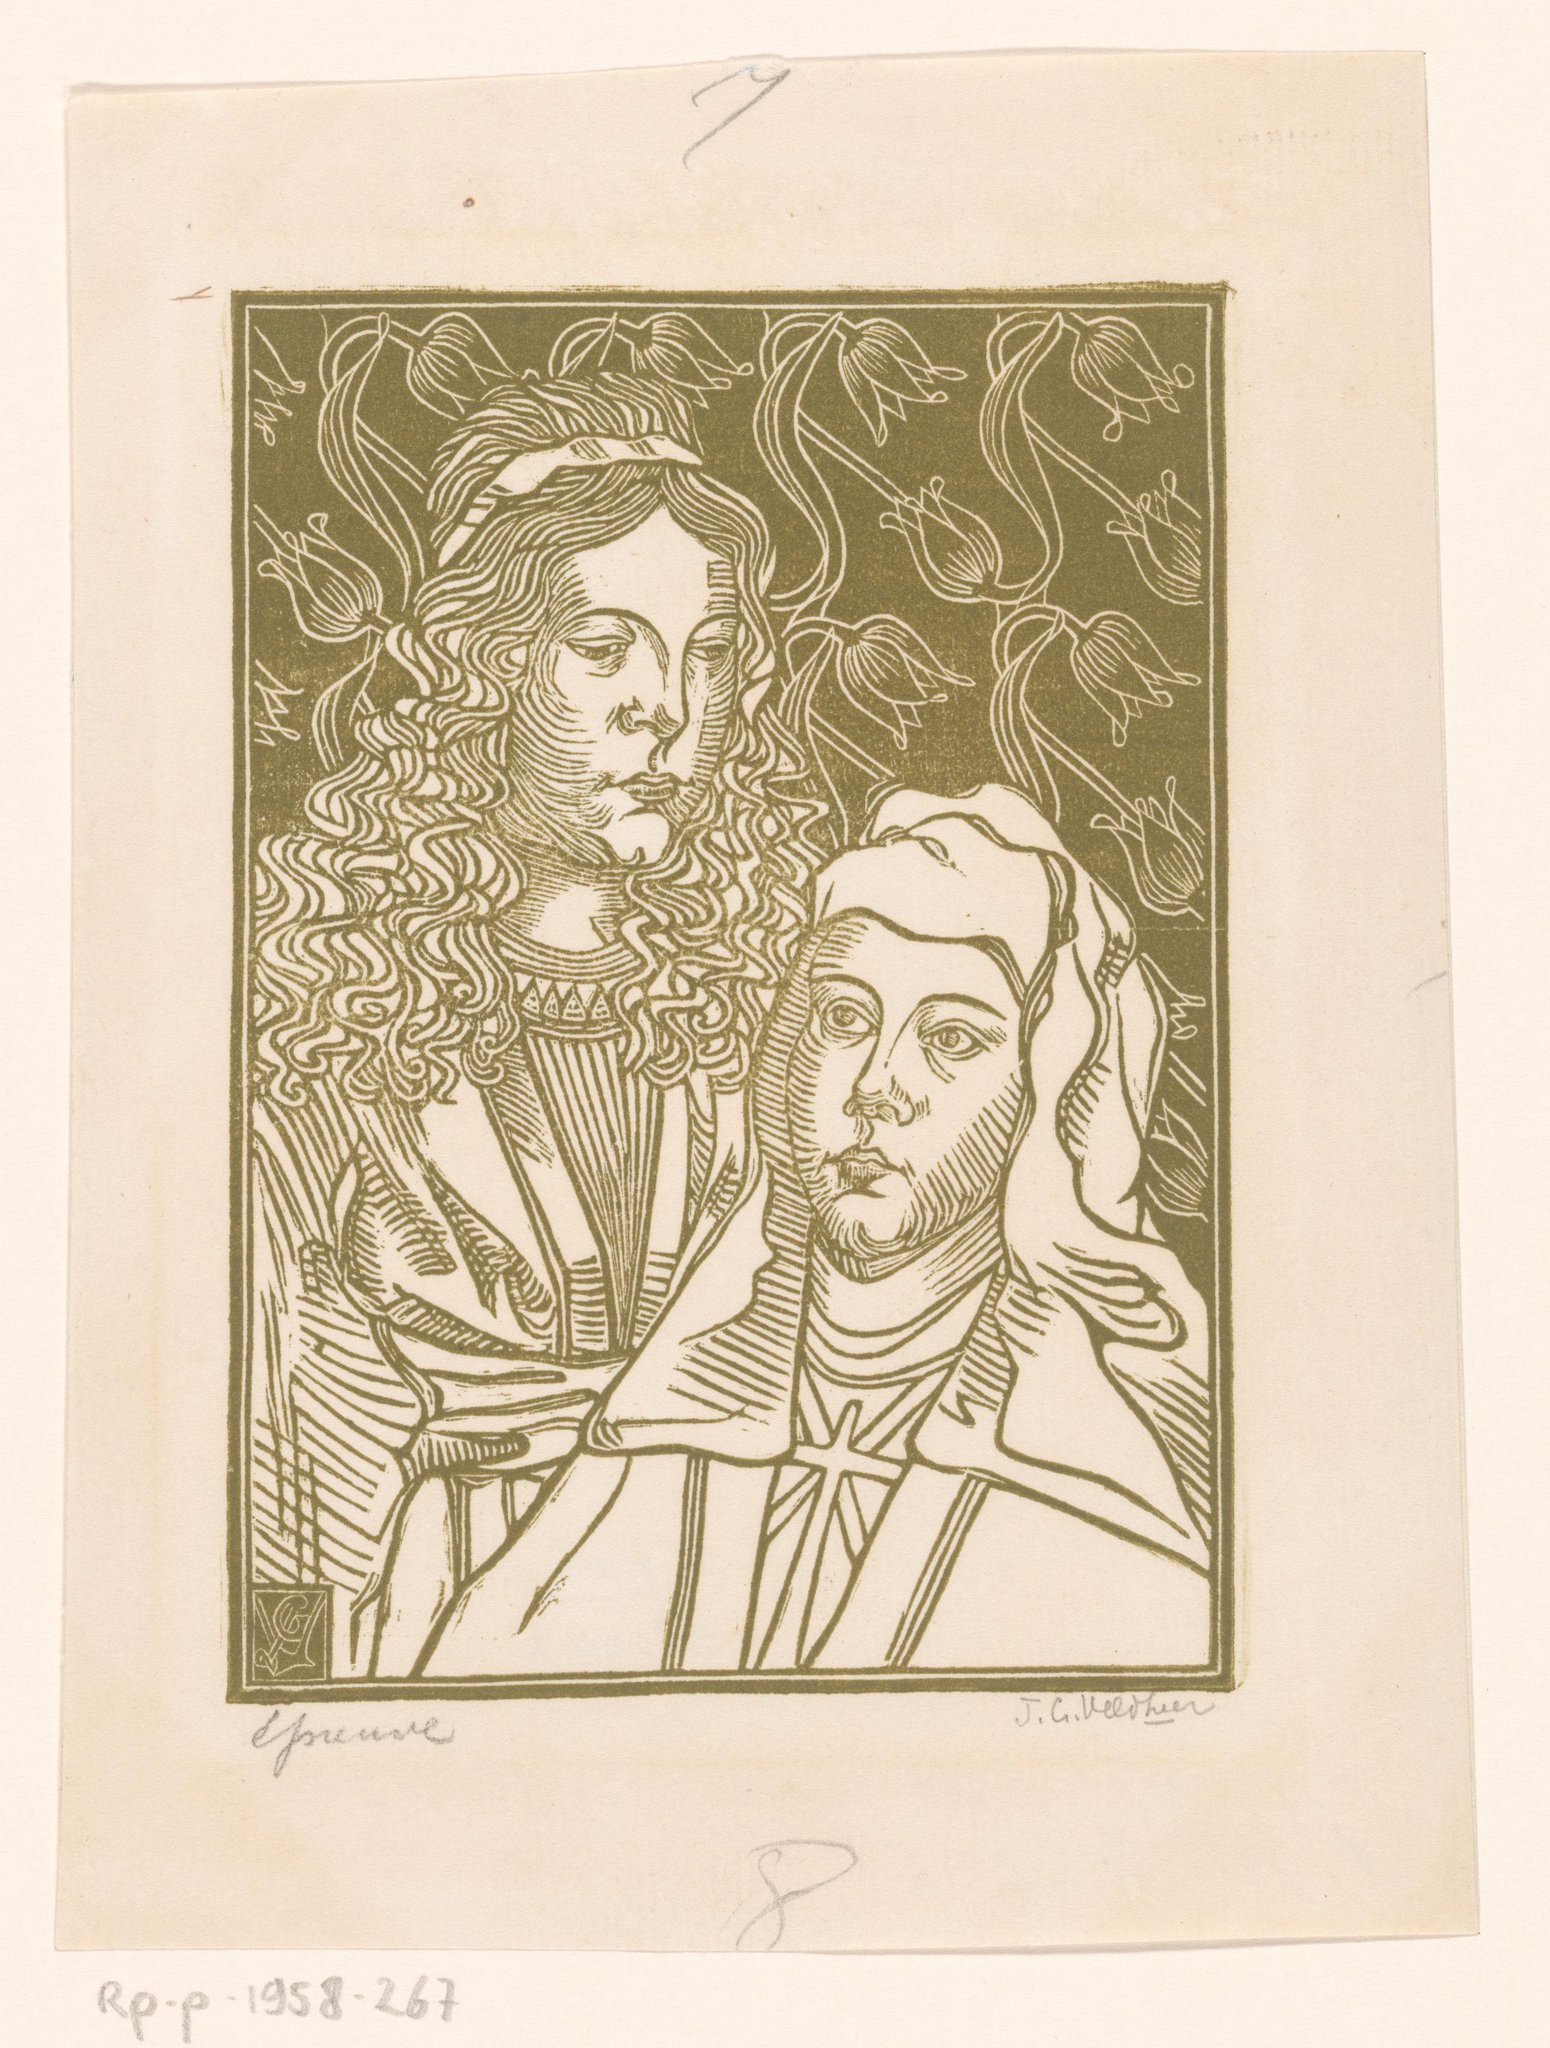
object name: print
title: Twee vrouwen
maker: jacobus gerardus veldheer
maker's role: draughtsman, print maker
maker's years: 1866-1954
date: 1876-1952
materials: paper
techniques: woodcut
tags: adult woman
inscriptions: collector's mark: Lugt 2228